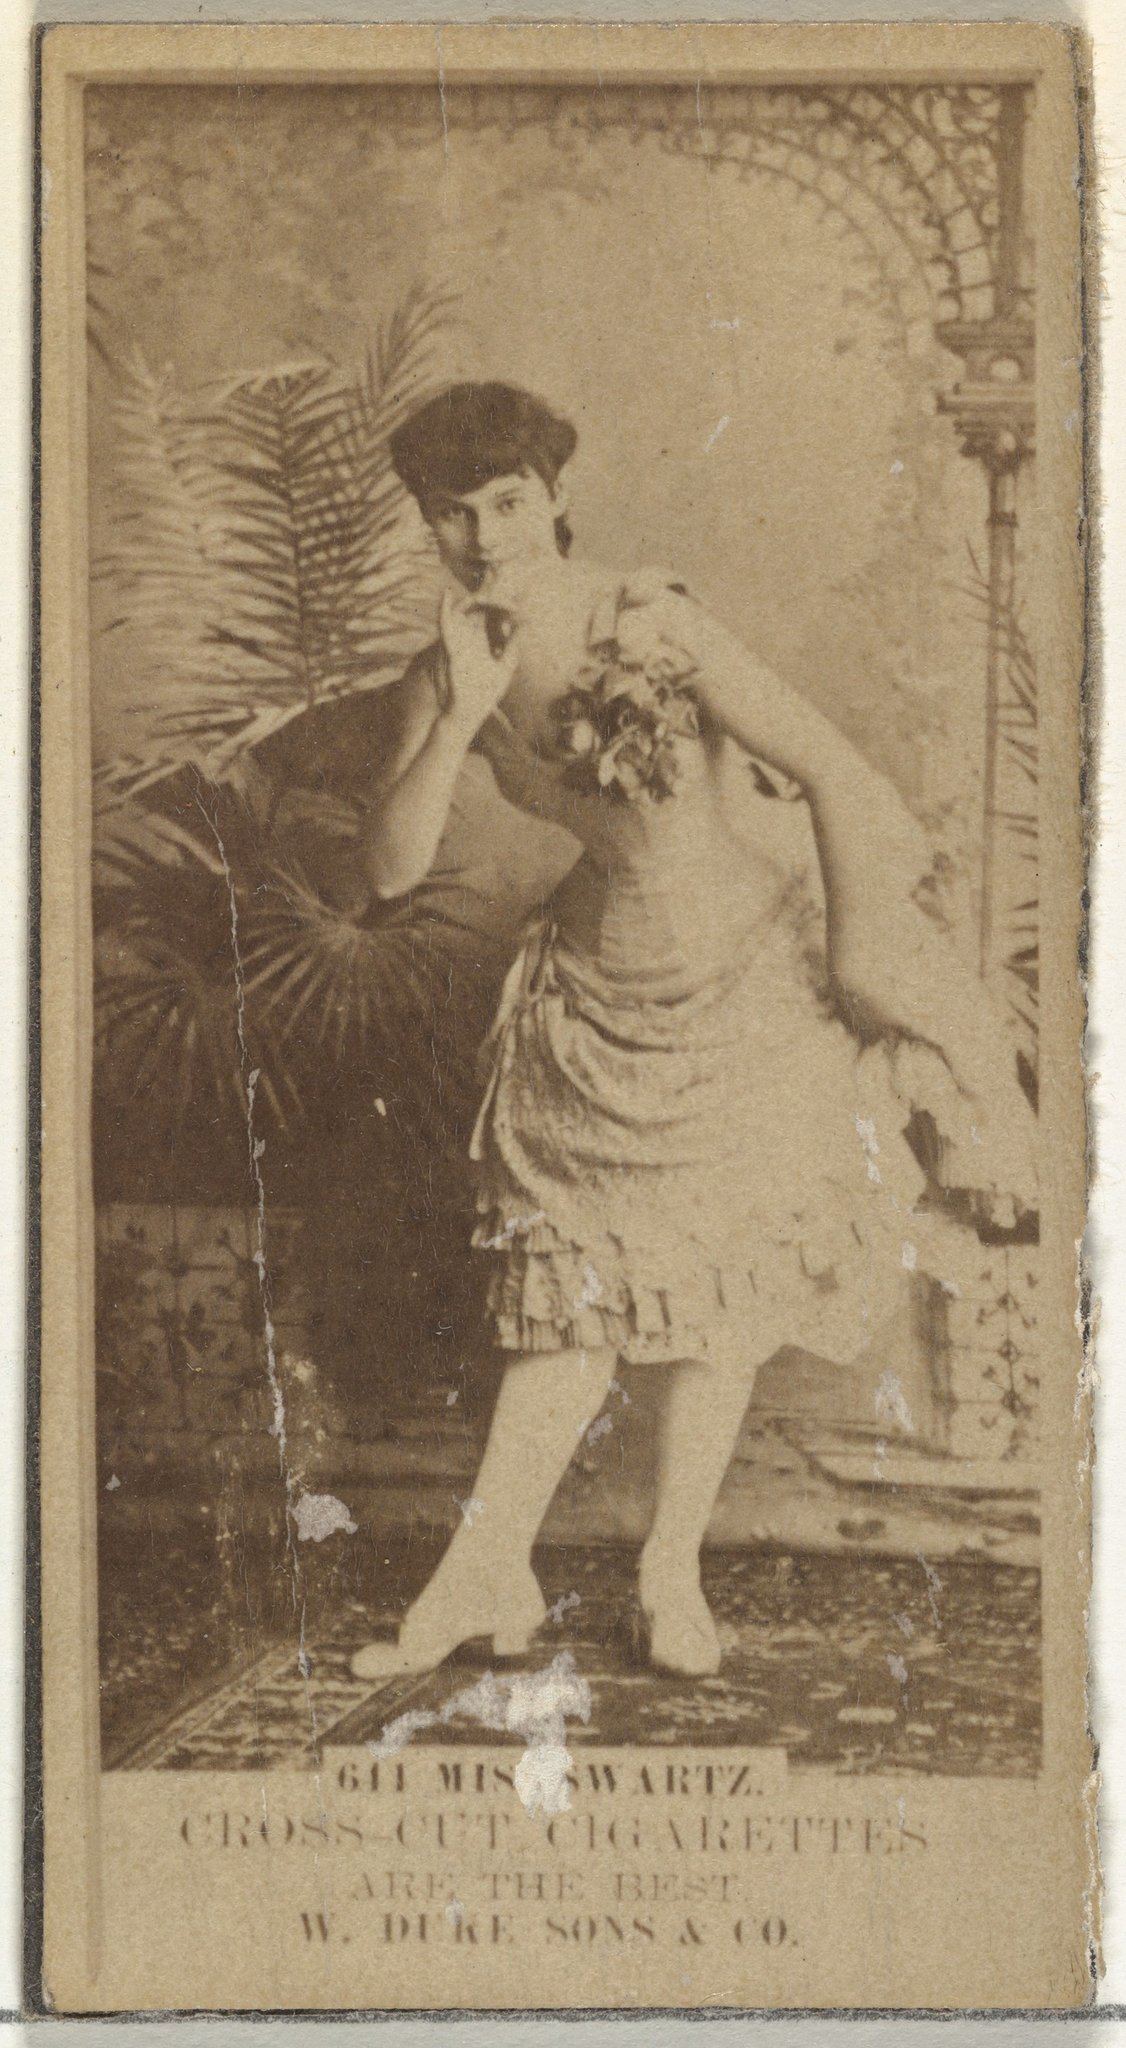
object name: photograph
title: Card Number 644, Miss Schwartz, from the Actors and Actresses series (N145-3) issued by Duke Sons & Co. to promote Cross Cut Cigarettes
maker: w. duke, sons & co.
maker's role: publisher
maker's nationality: american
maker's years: 1870-1920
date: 1880-1889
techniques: albumen silver print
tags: portraits,women,actresses